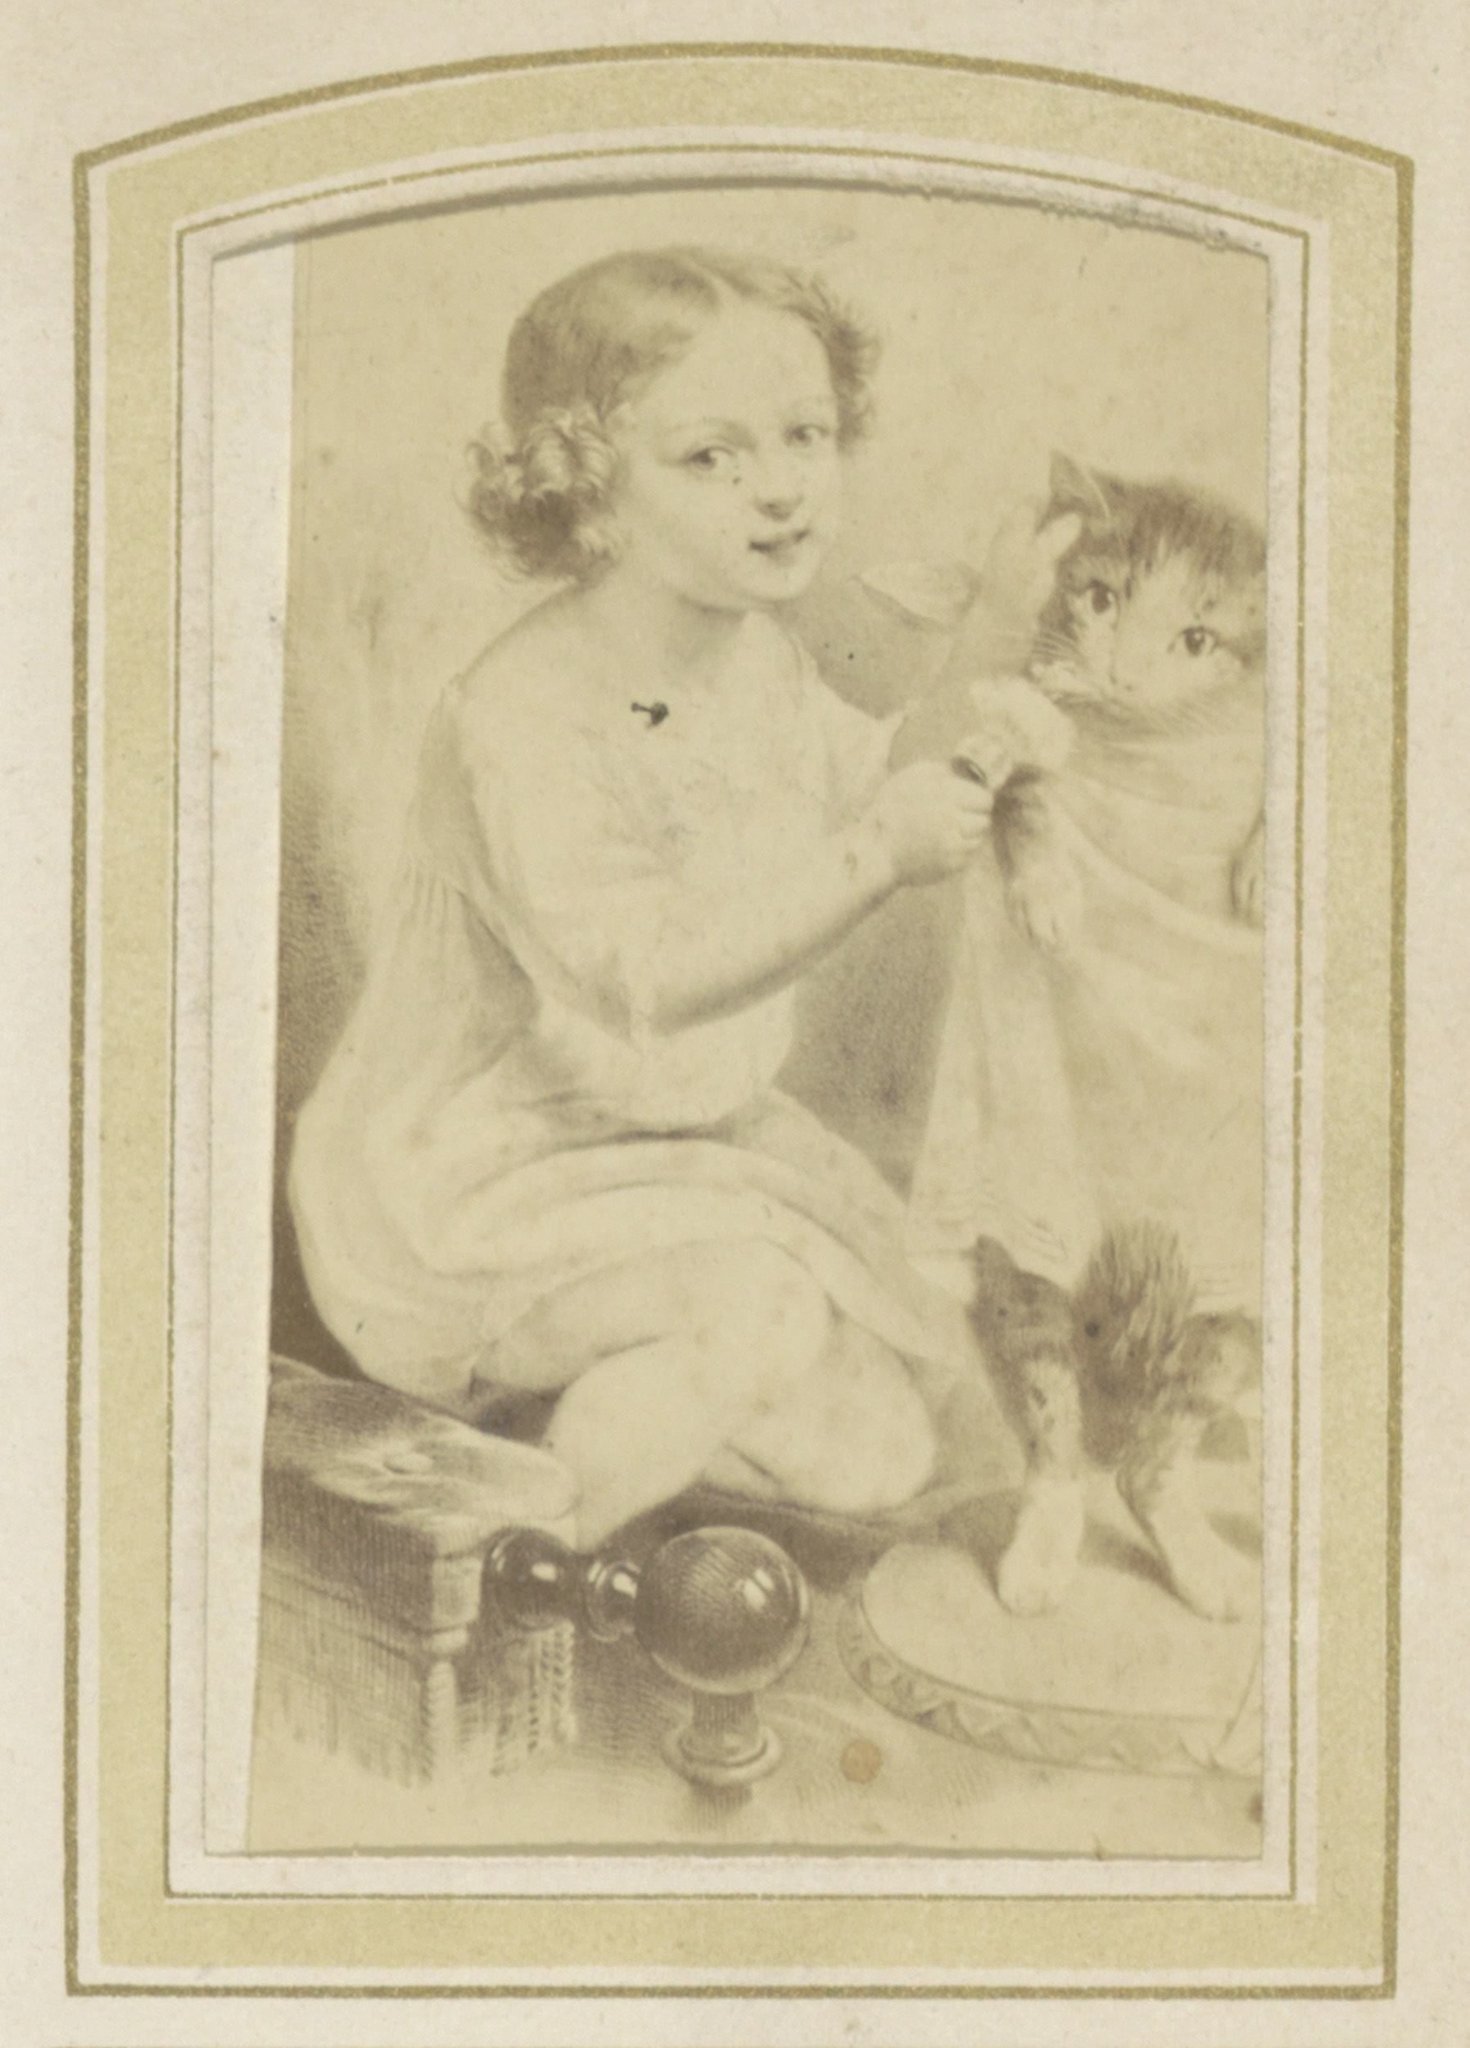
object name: photograph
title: Fotoreproductie van een prent van een kind dat een kat aankleedt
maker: Anonymous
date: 1860-1900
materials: cardboard, paper, photographic support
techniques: albumen print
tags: cat, child, child playing with animals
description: Onderdeel van Fotoalbum van een Nederlandse familie met 168 cartes-de-visite en kabinetfoto's.